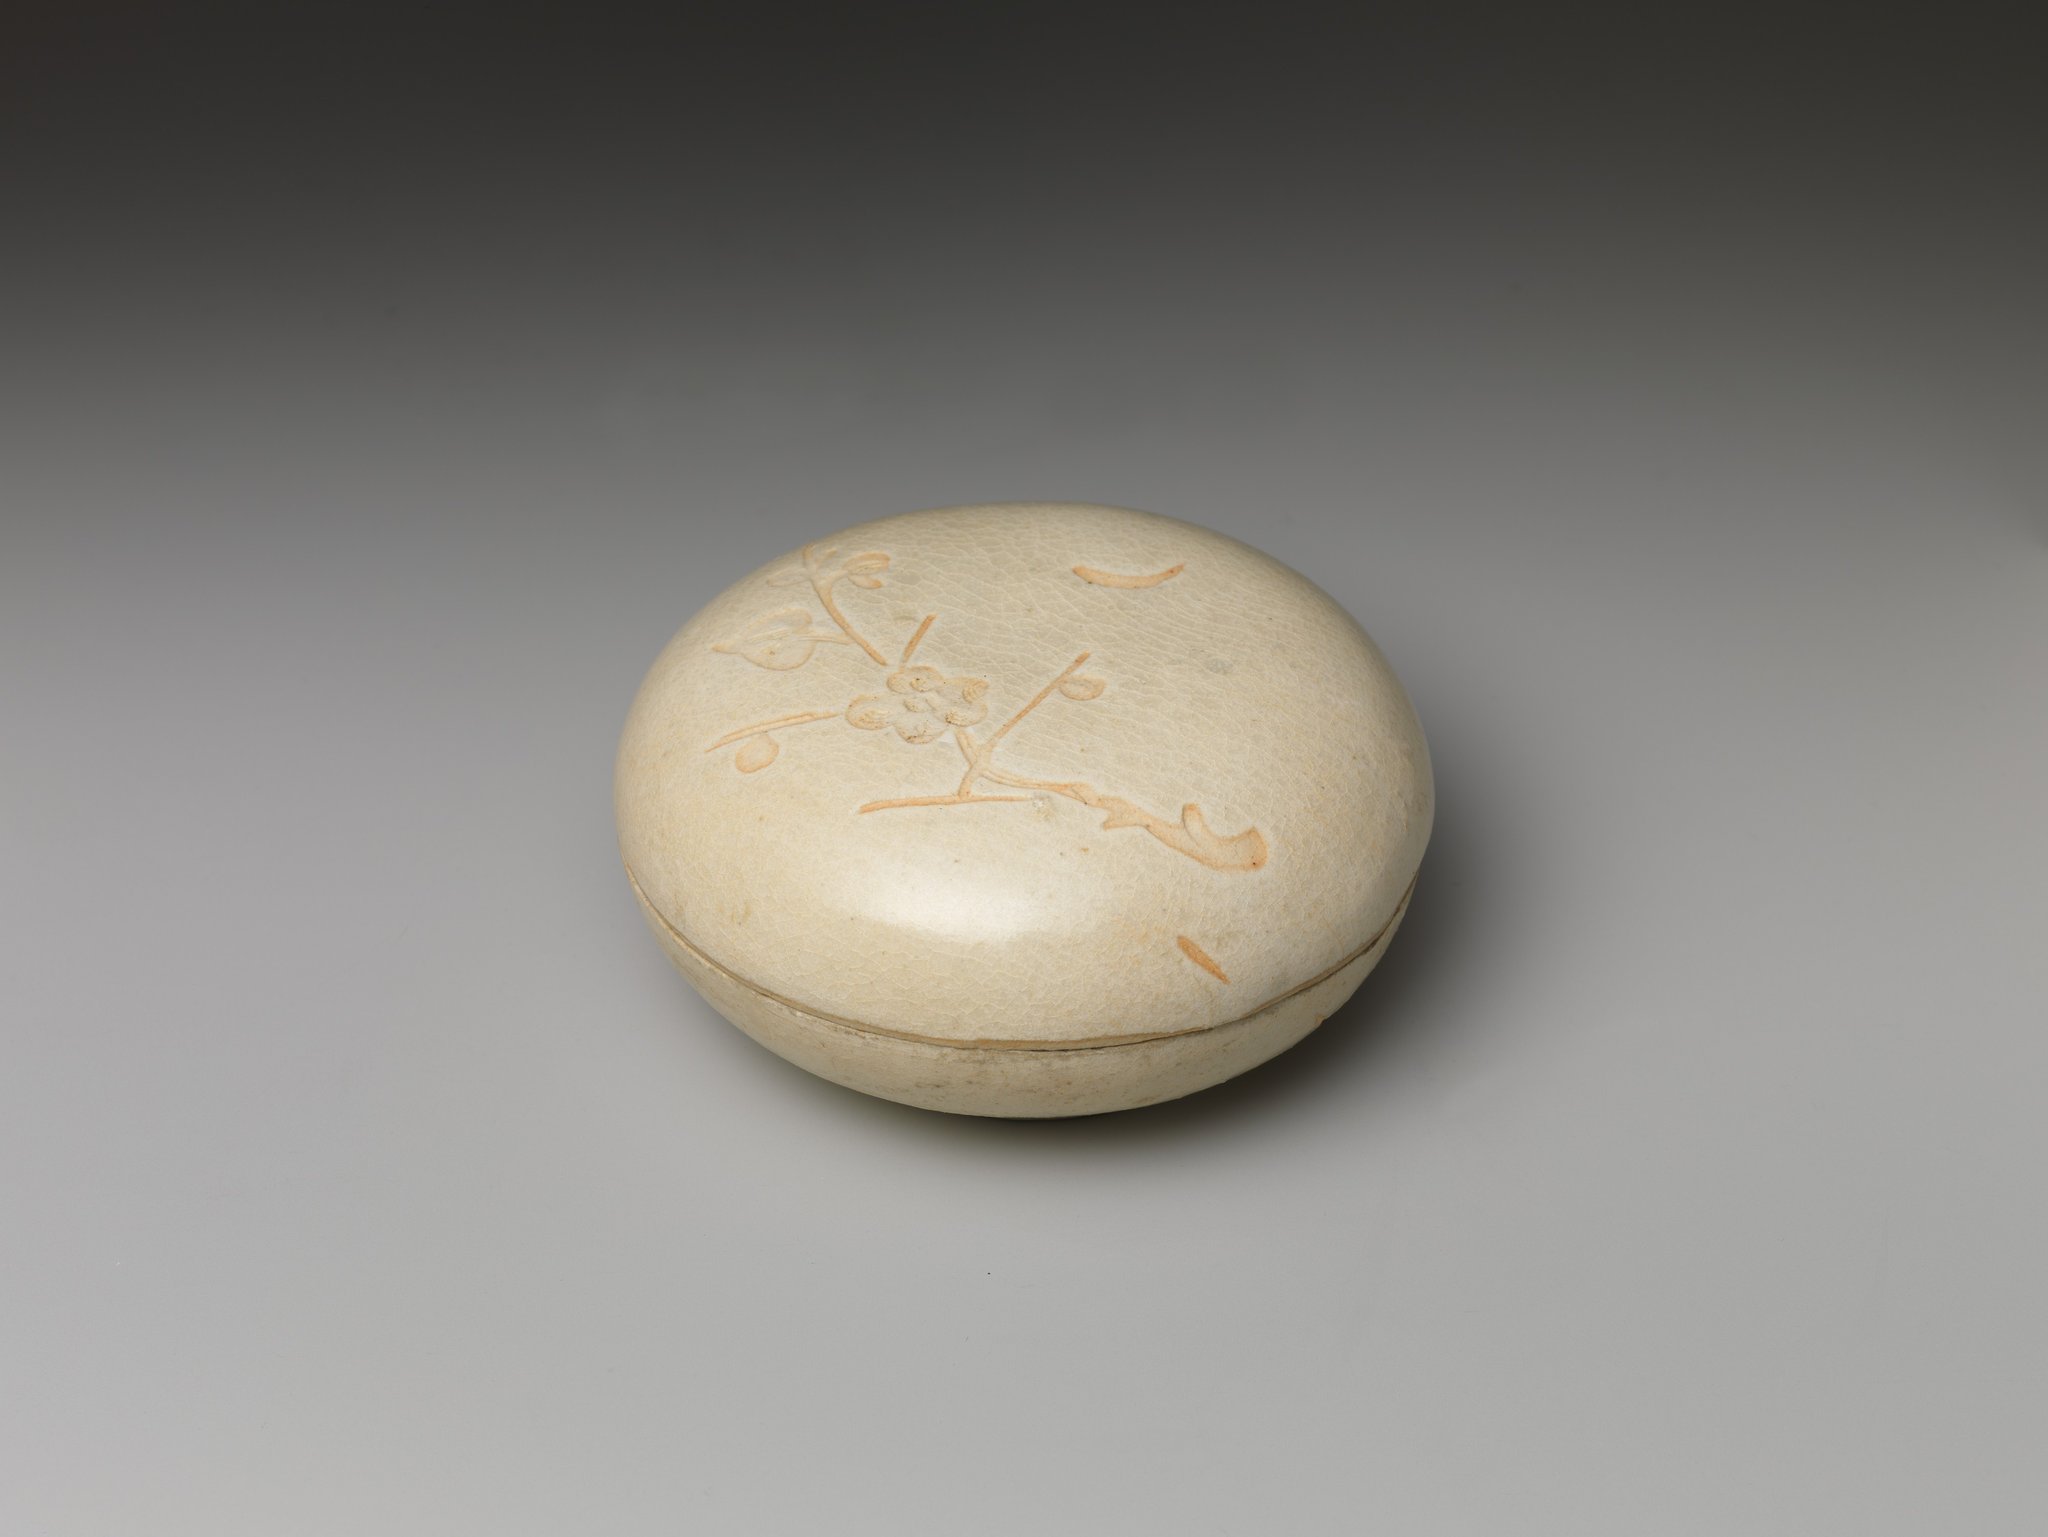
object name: covered box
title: Covered box with flowering plum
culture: chinese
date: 1201-1400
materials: glaze, porcelain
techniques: cutting